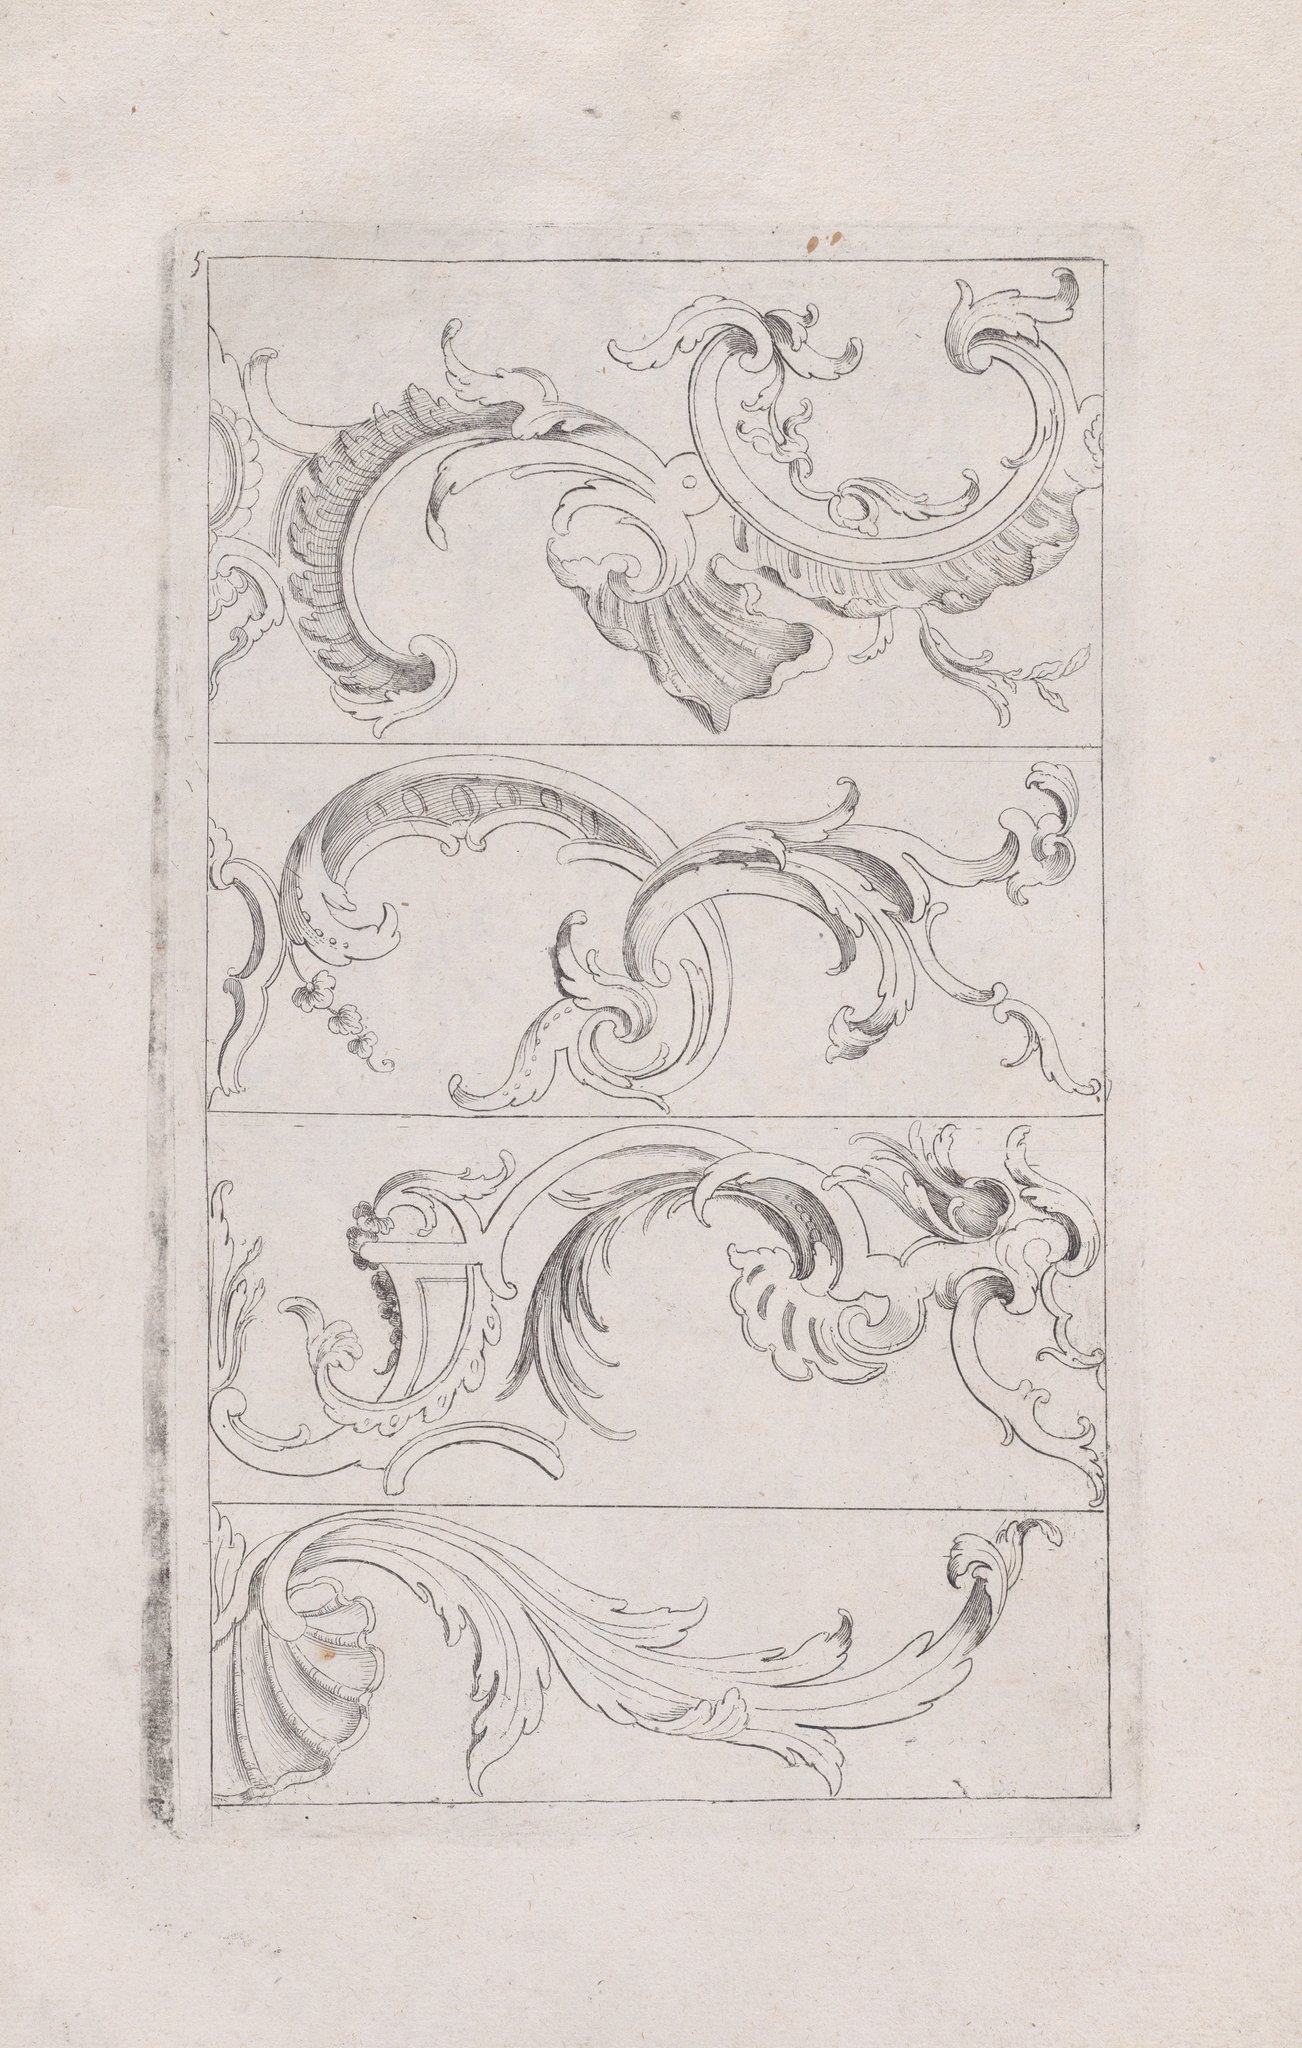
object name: print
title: Plate 5, from "Livre Nouveau de Prinsipes D'Ornemens, tres facil. Pour apprendre a Dessigner"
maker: nicolas guérard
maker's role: artist and publisher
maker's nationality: french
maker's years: 1648-1719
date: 1715-1725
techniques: engraving